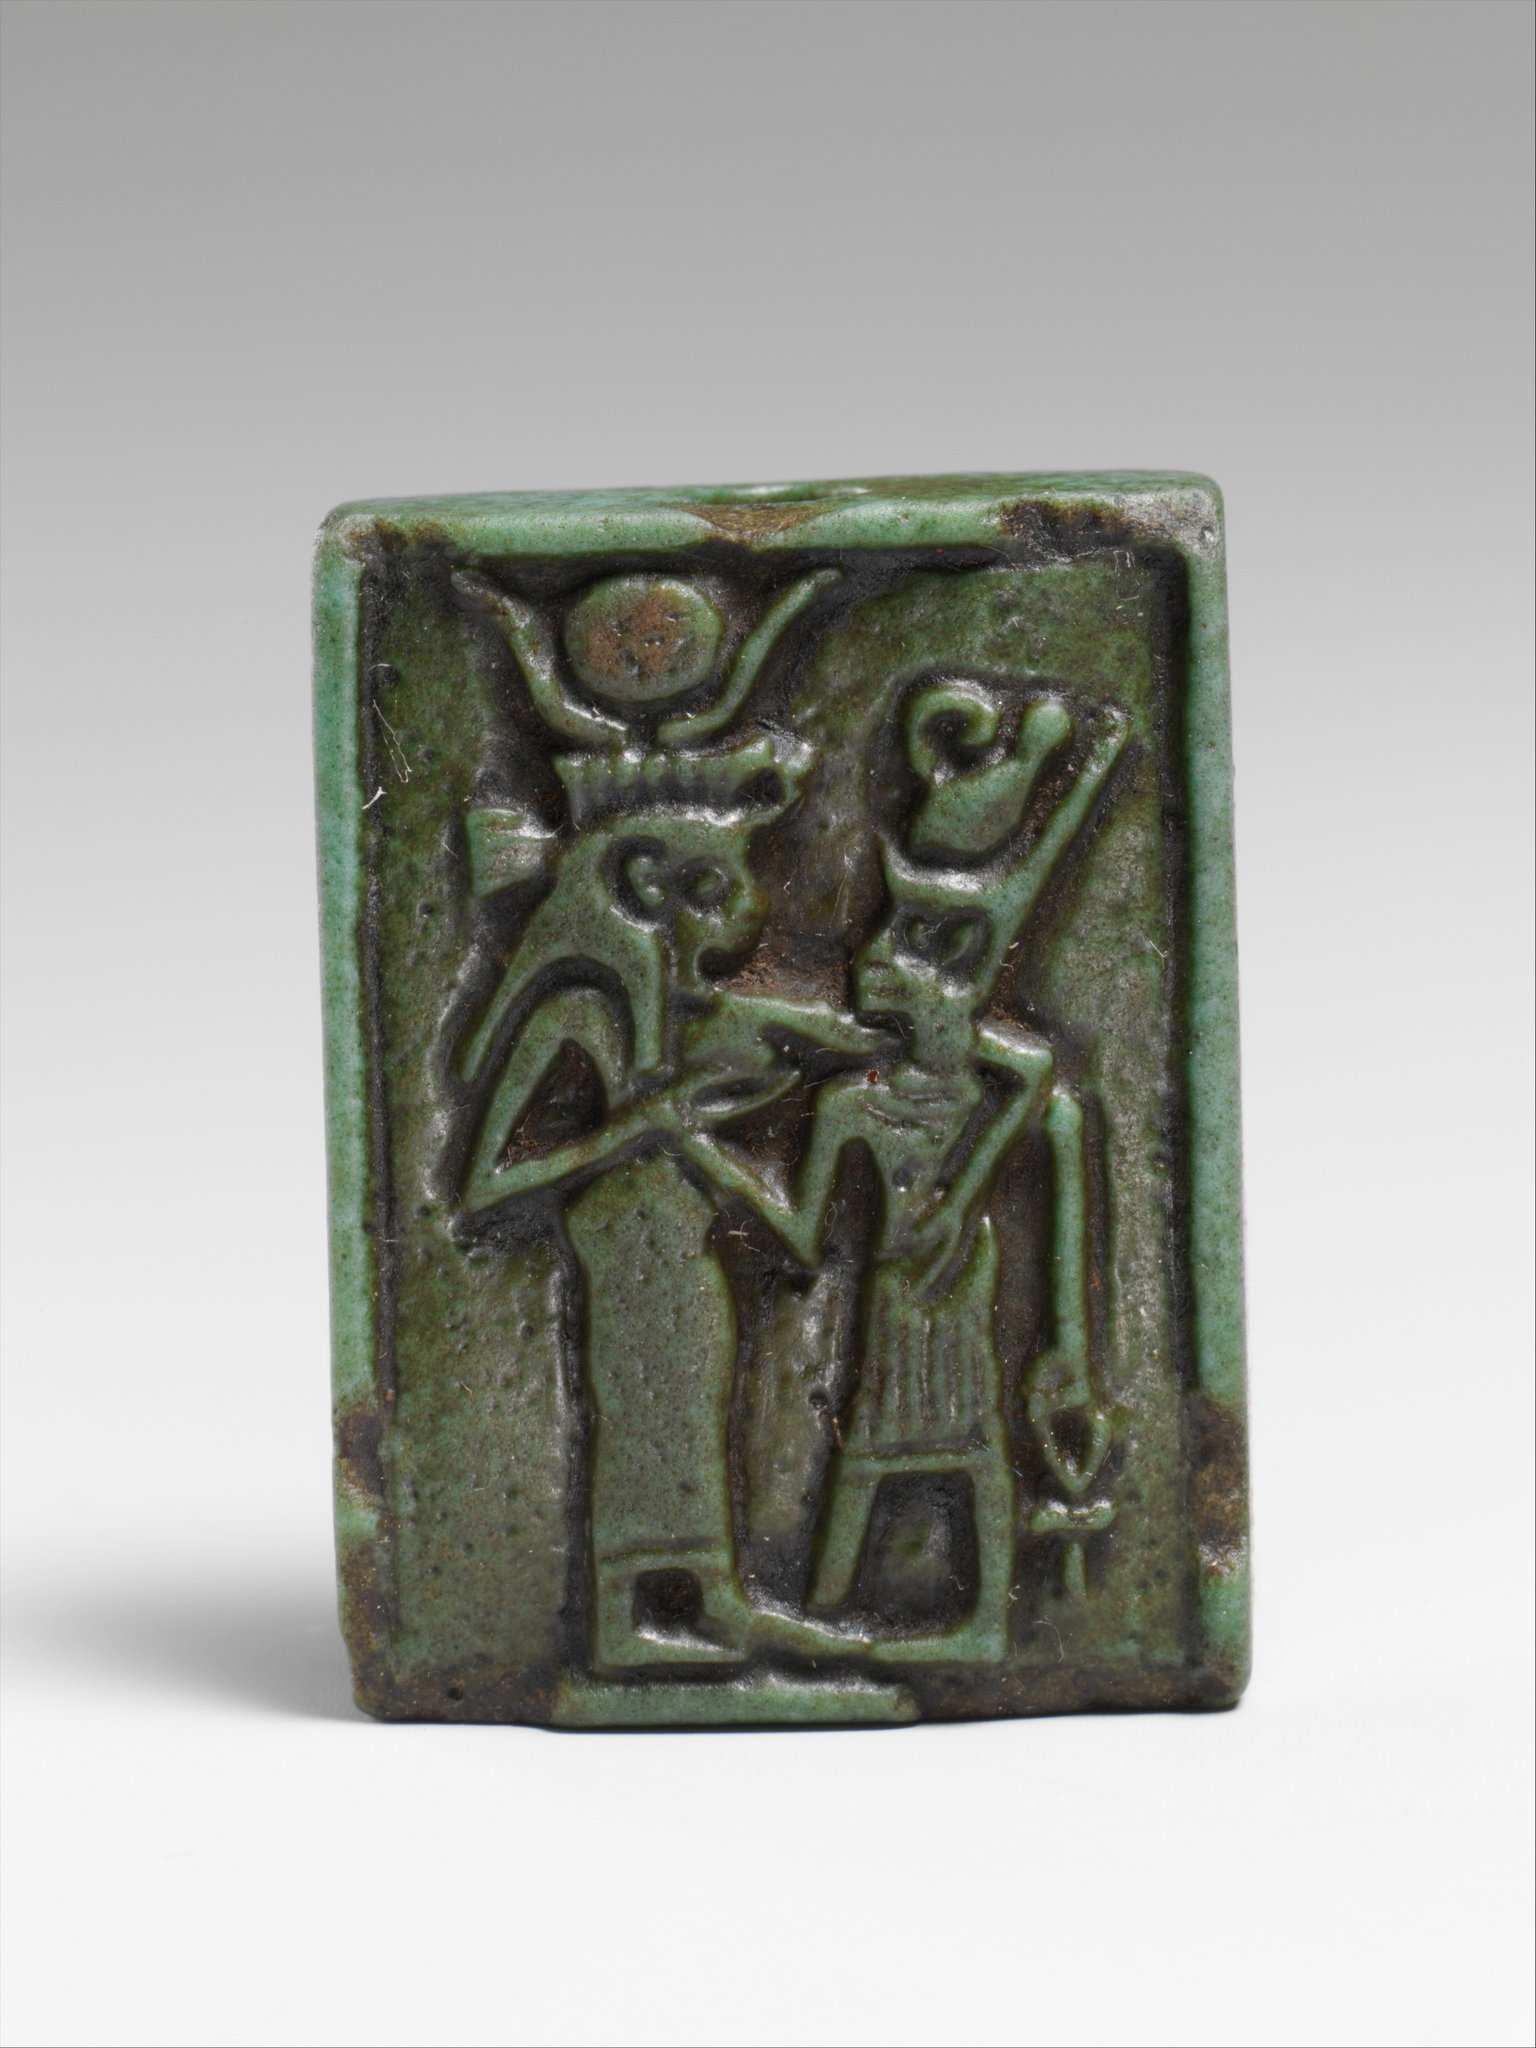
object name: amulet plaque, isi nourishing a king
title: Faience amulet plaque of Isis nourishing a pharaoh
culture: egyptian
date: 1050-900 BCE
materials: faience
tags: men,isis